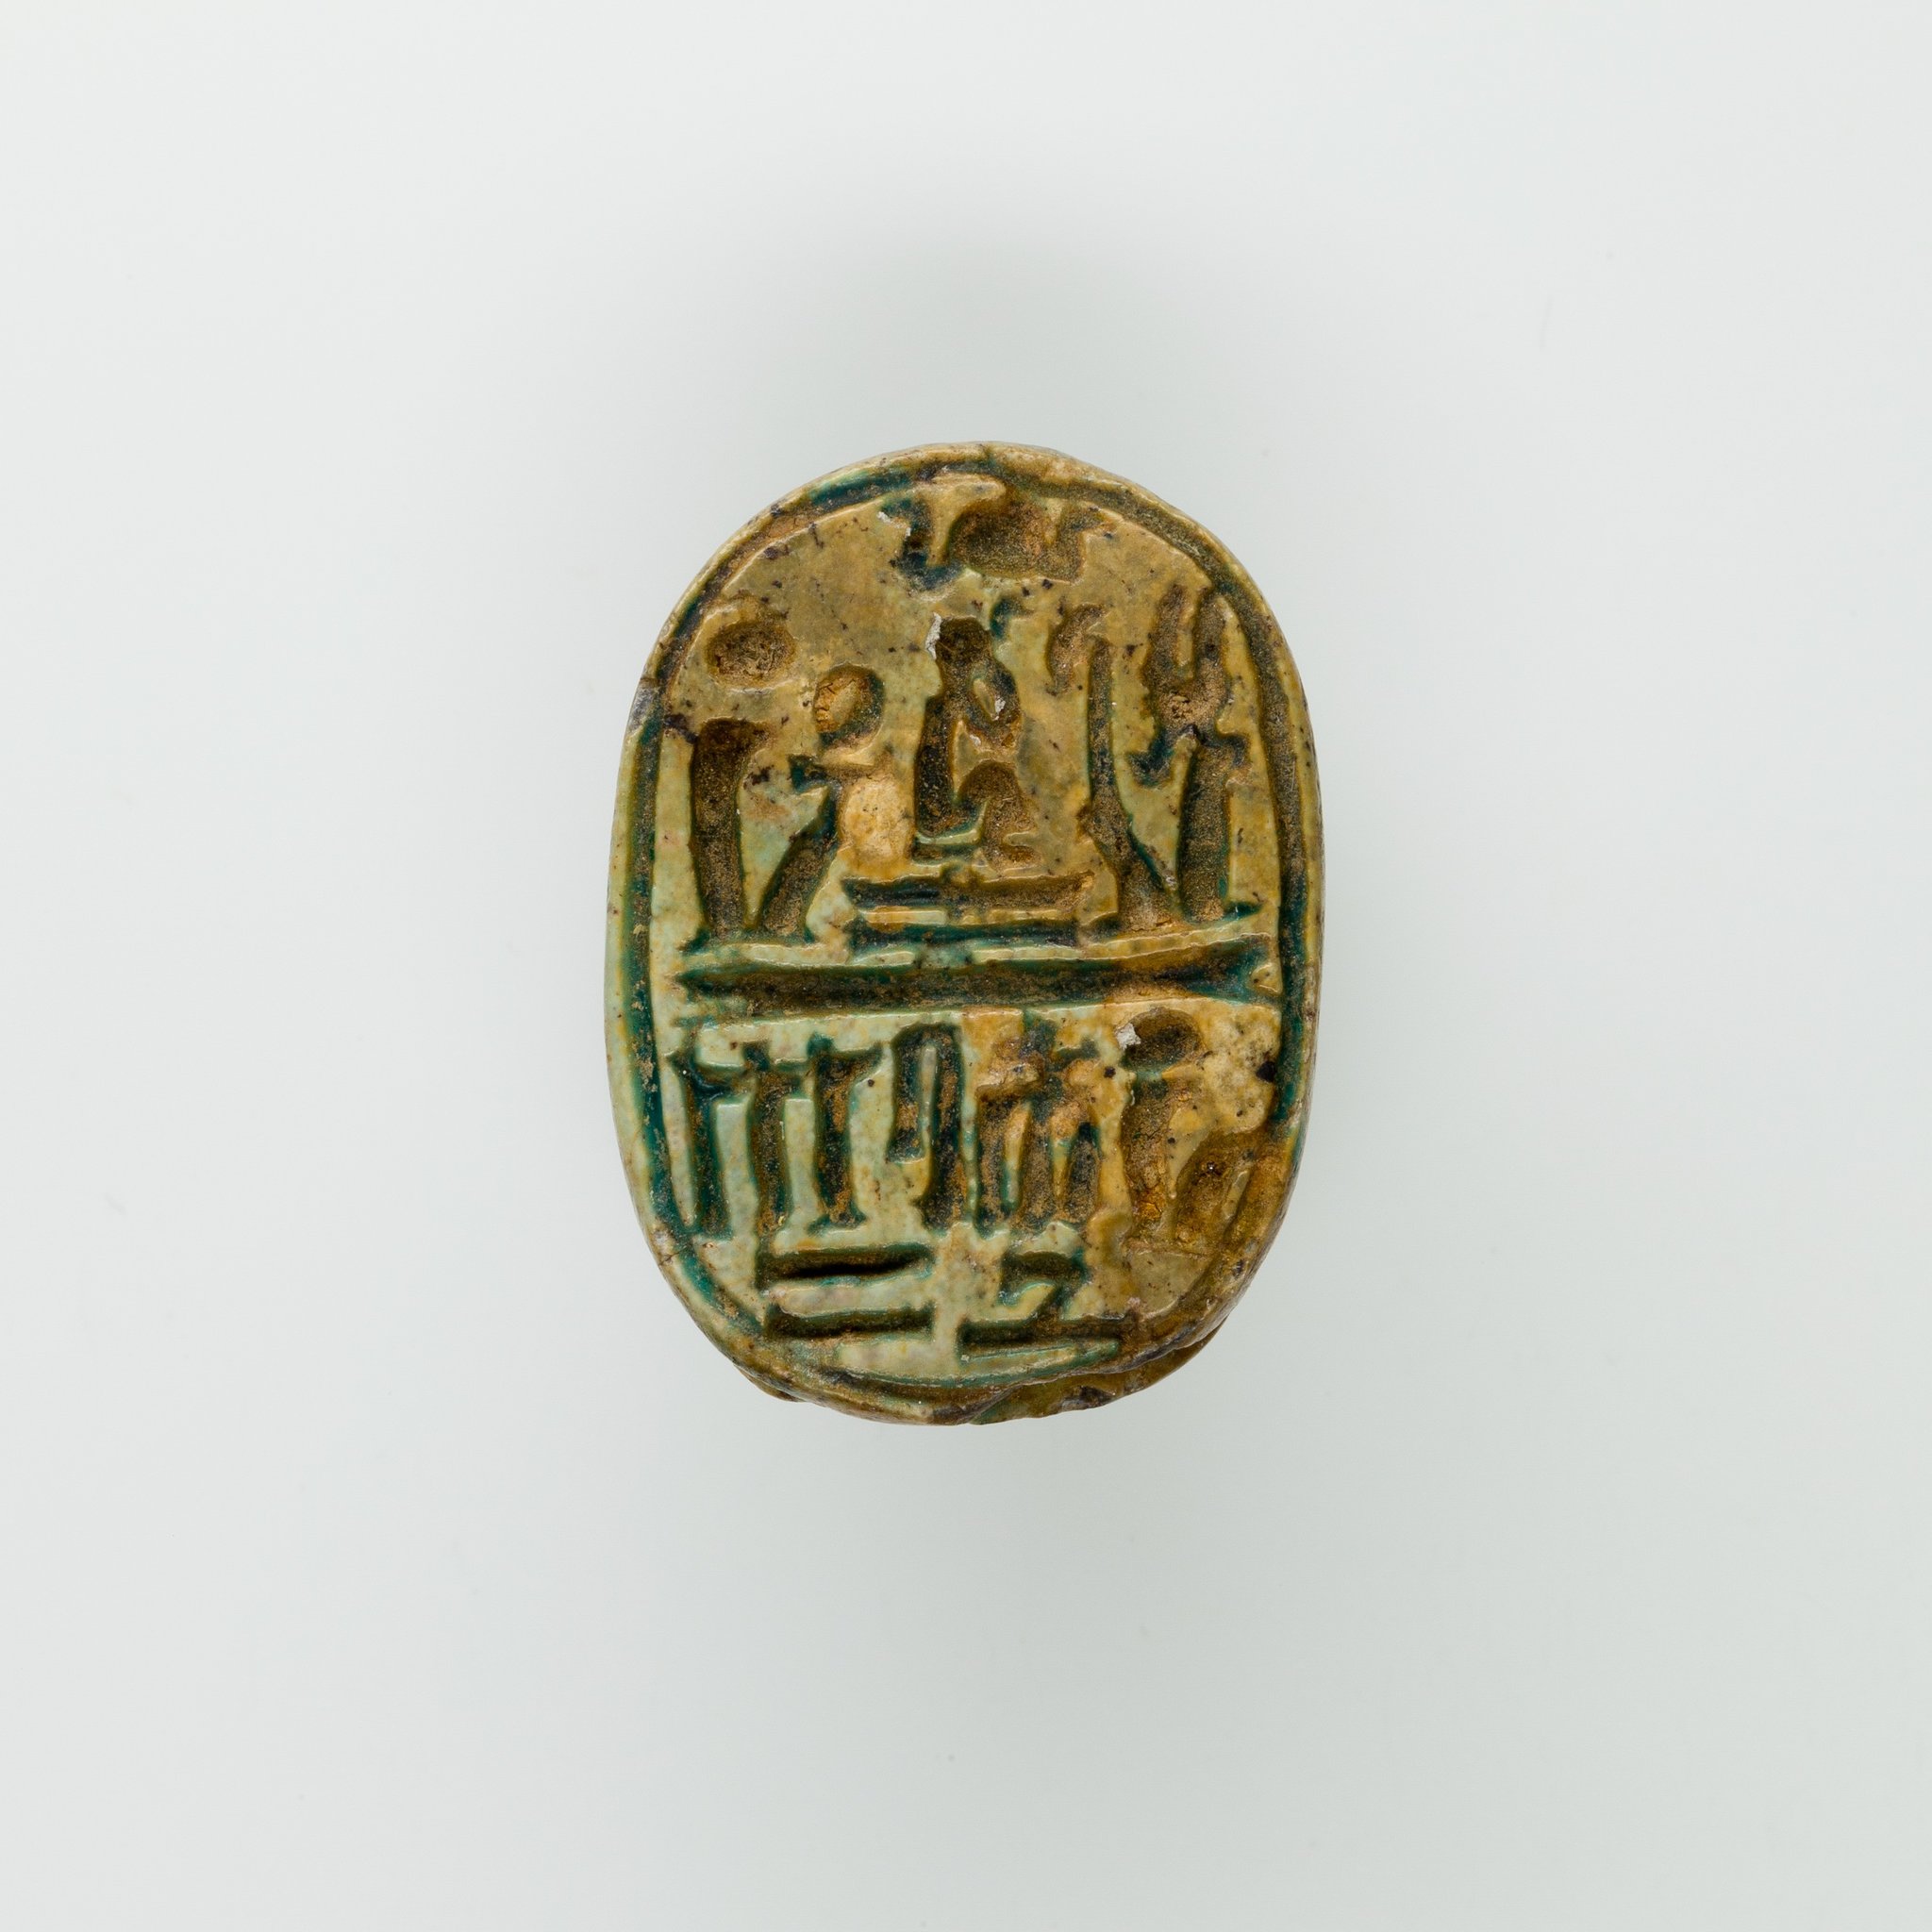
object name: scarab, ramesses ii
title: Scarab of Ramesses II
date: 1295-1070 BCE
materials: stone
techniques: glazing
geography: egypt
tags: hieroglyphs,scarabs